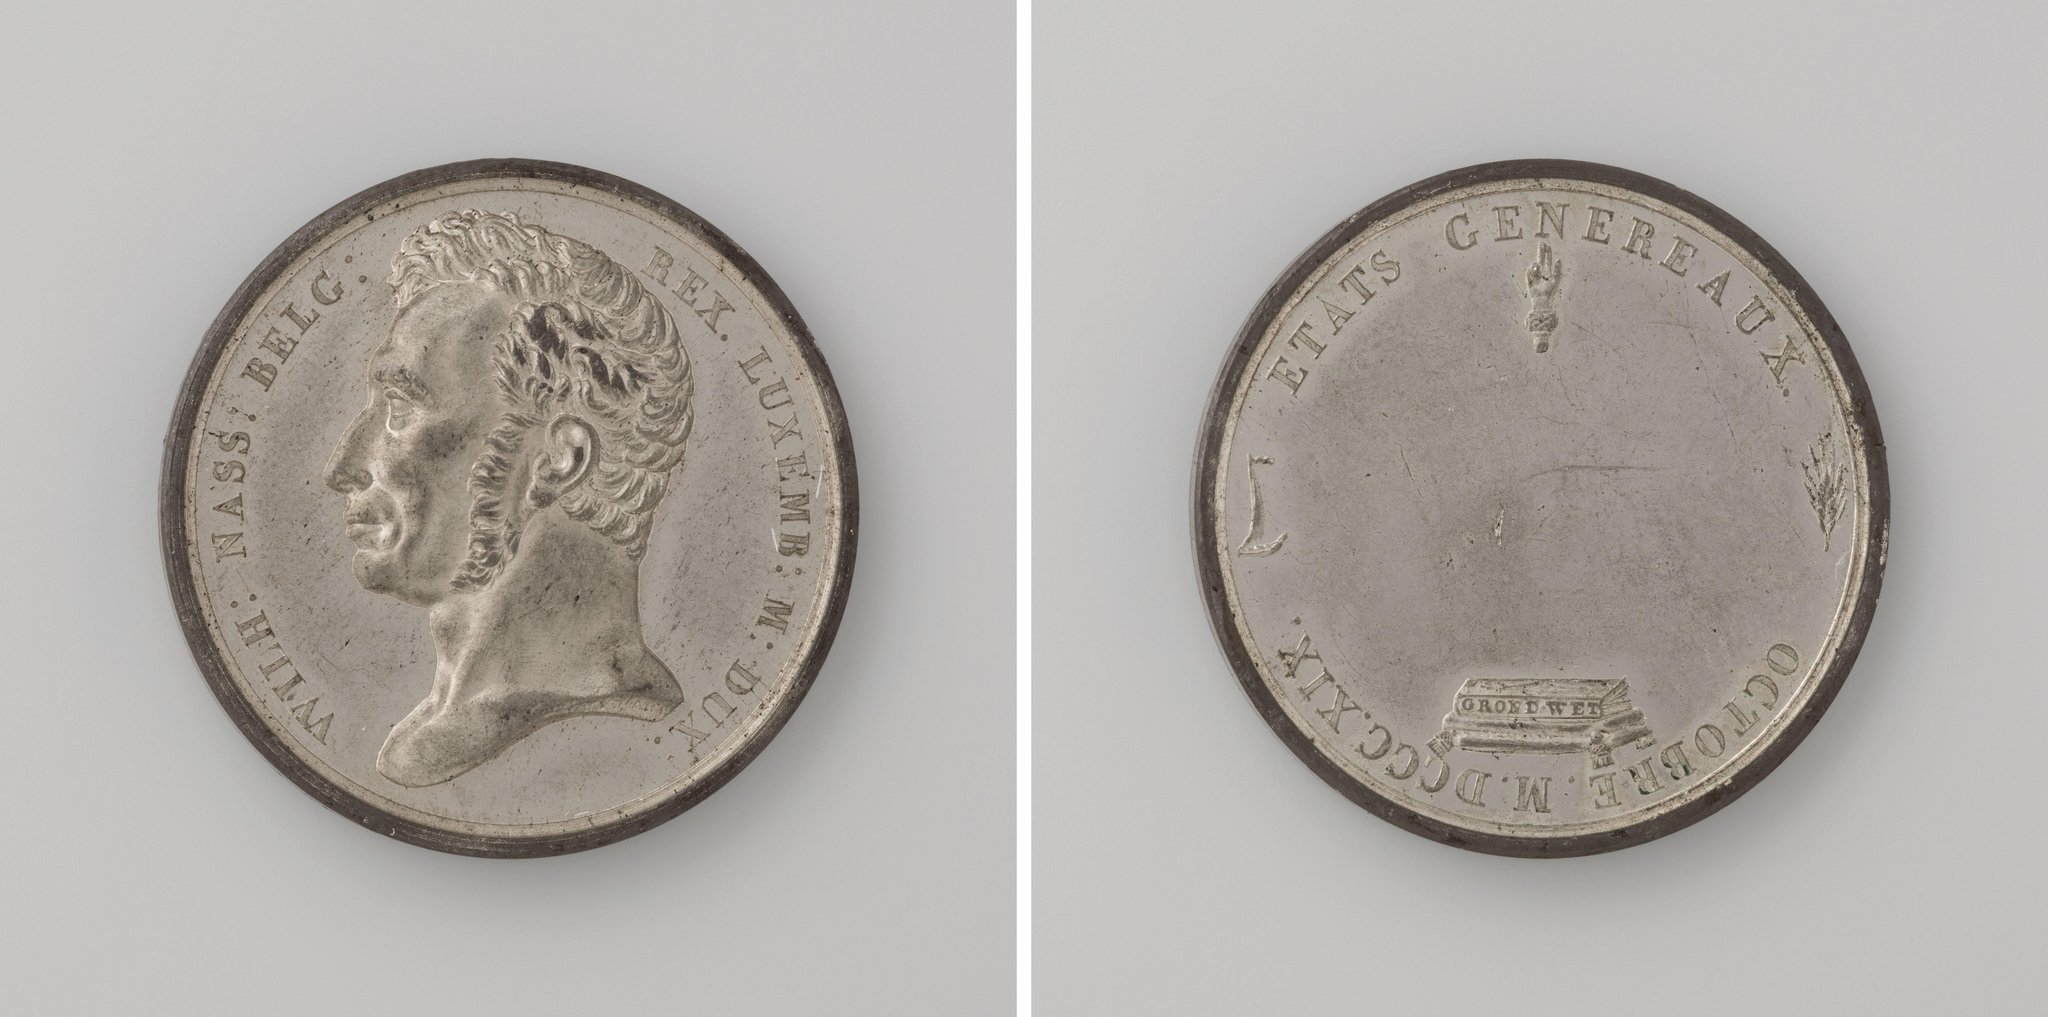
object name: history medal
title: Opening van de Staten-Generaal, ter ere van Willem I Frederik, koning der Nederlanden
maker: auguste francois michaut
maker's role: sculptor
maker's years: 1786-1879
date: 1819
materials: composition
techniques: striking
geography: netherlands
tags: berlin, william i of the netherlands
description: Voorzijde: borststuk man binnen omschrift. Keerzijde: leeg veld met boven een zwerende hand, rechts schip, links korenaar en onder boek met opschrift op rug liggend op kussen binnen omschrift